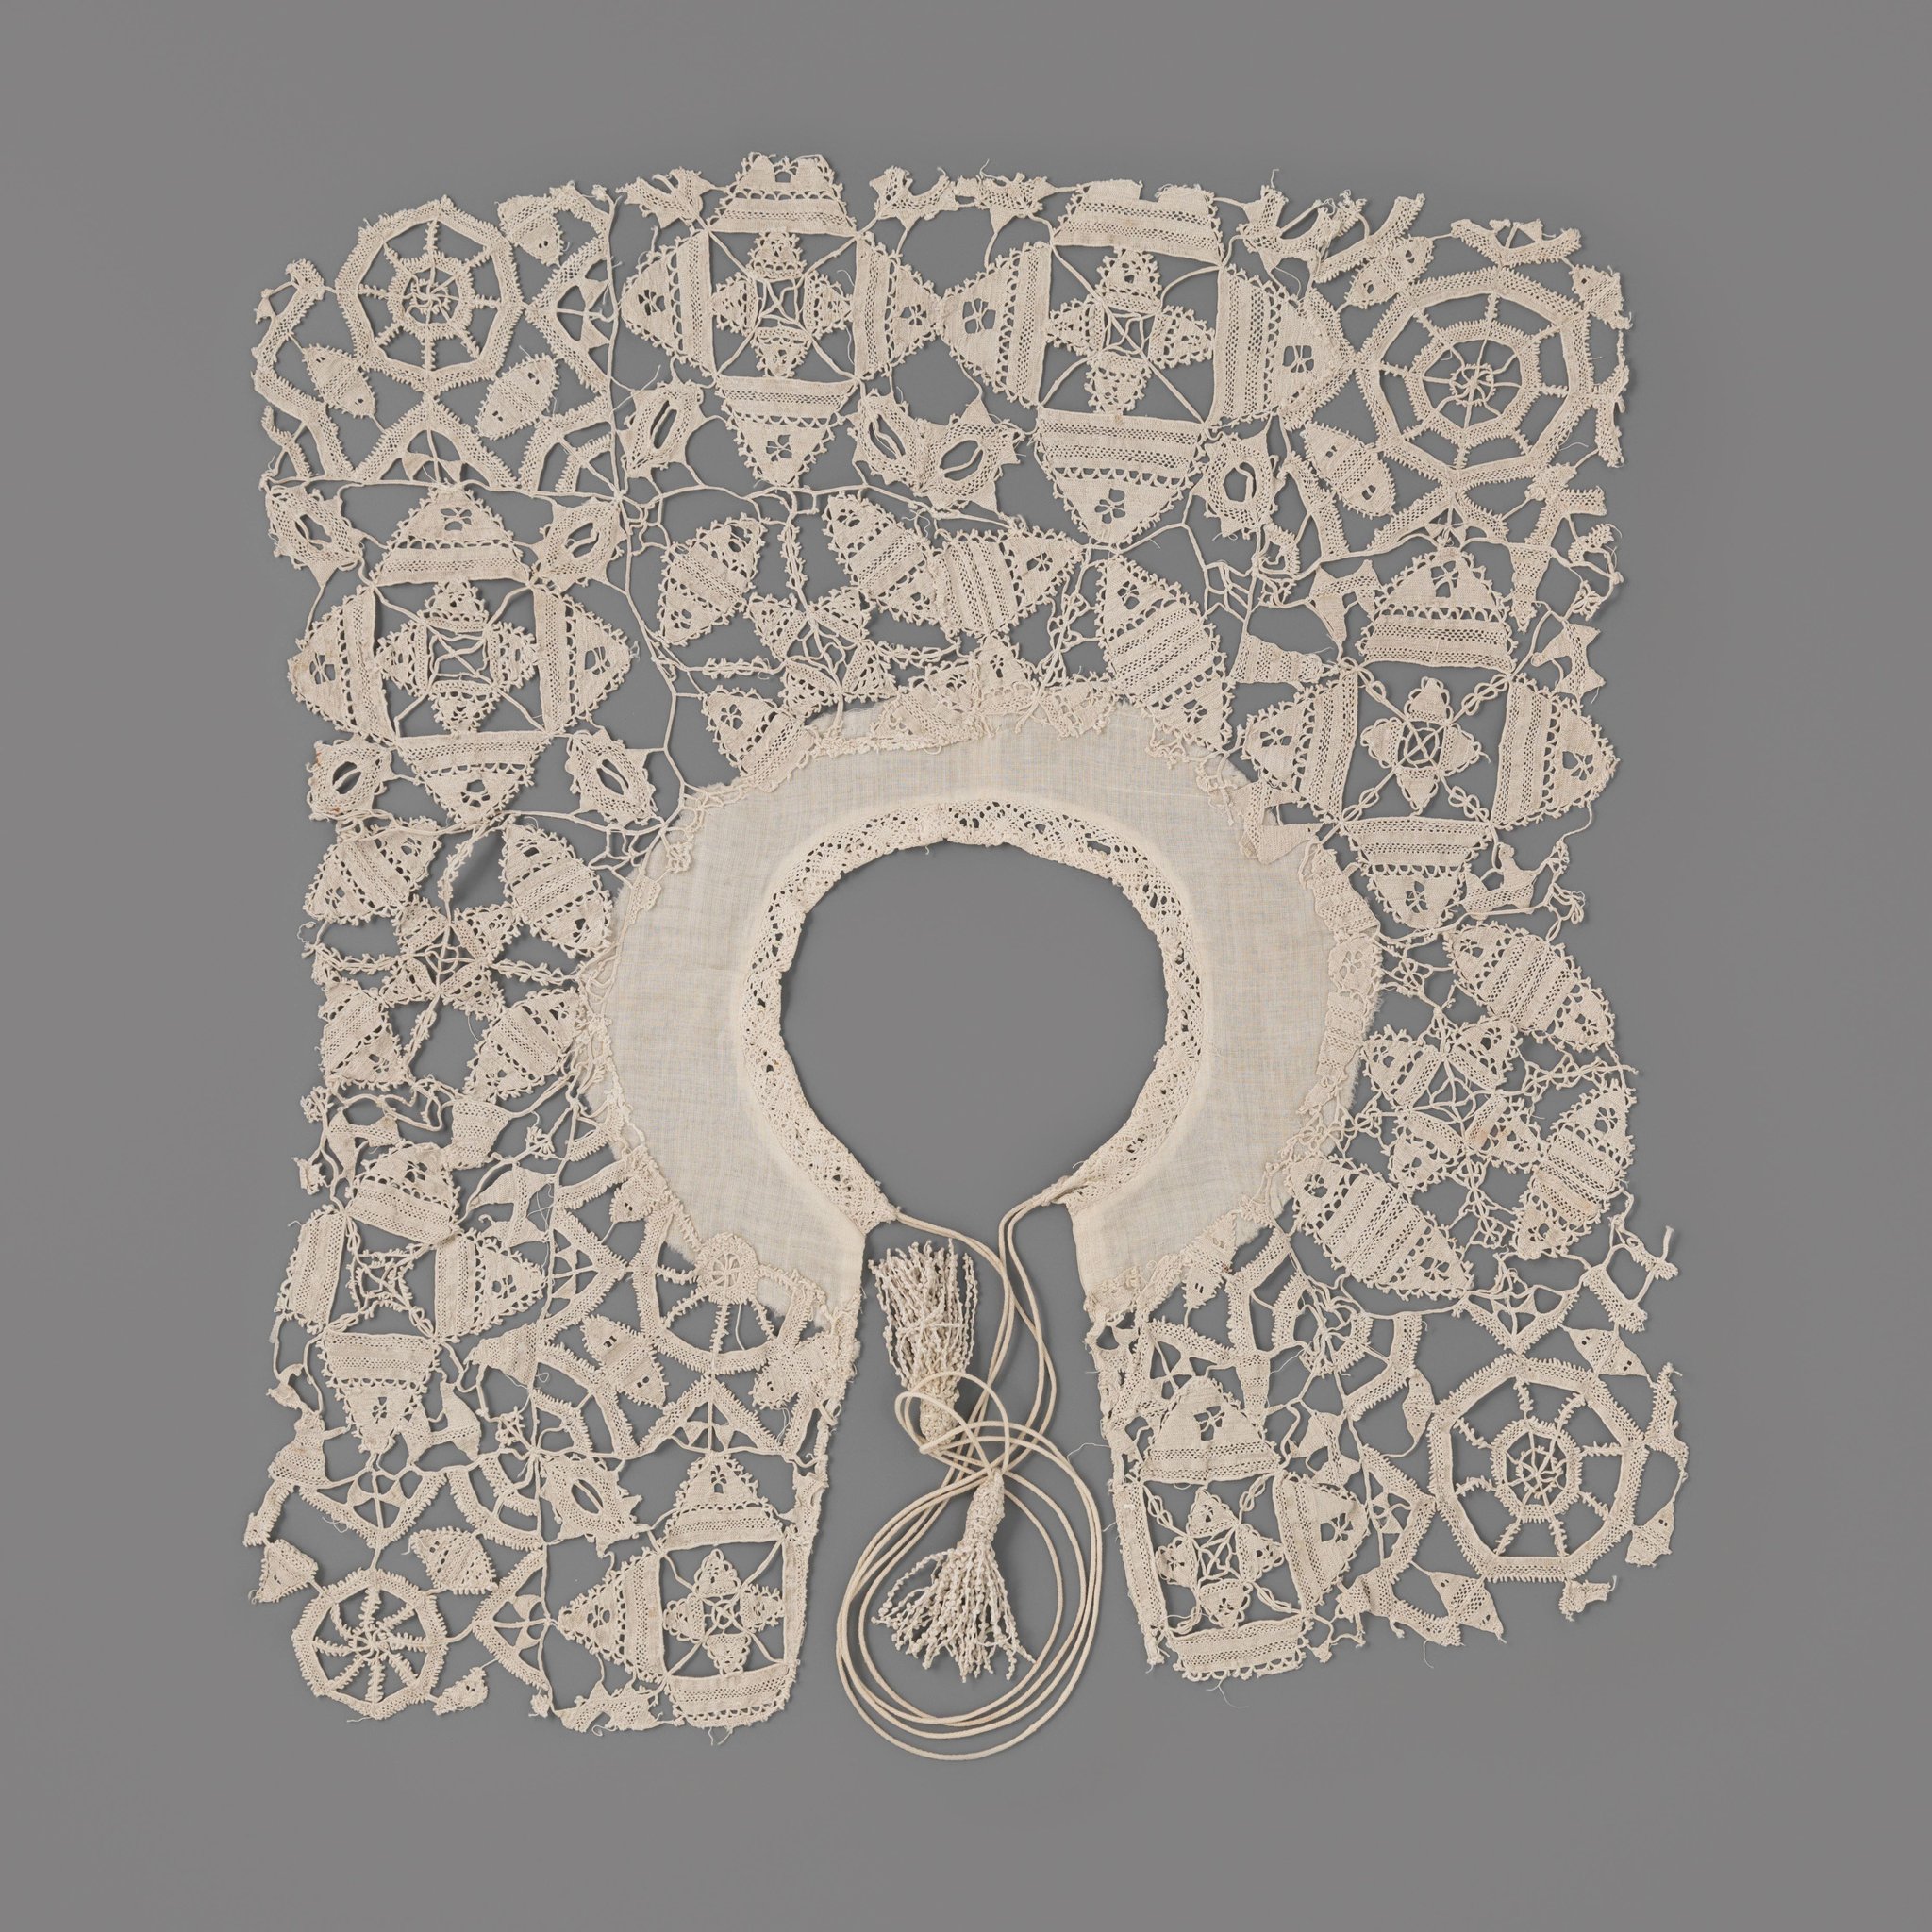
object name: clothing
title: Kraag van reticella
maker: Anonymous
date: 1575-1600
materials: cotton, linen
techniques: needle lace, reticella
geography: italy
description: Kraag van naaldkant, reticella. Techniek. Rond een katoenen halsstuk is een onafgwerkte kant gezet. Langs de binnenzijde een smal, gekloste antre-dene, beëindigd met twee koordjes met akertjes. Patroon: grote vierkanten zijn om beurten gevuld met een rad, kruisgewijs geplaatste driehoekjes of ellipsen. Grote lange spijlen vormen de spaken en diagonalen.